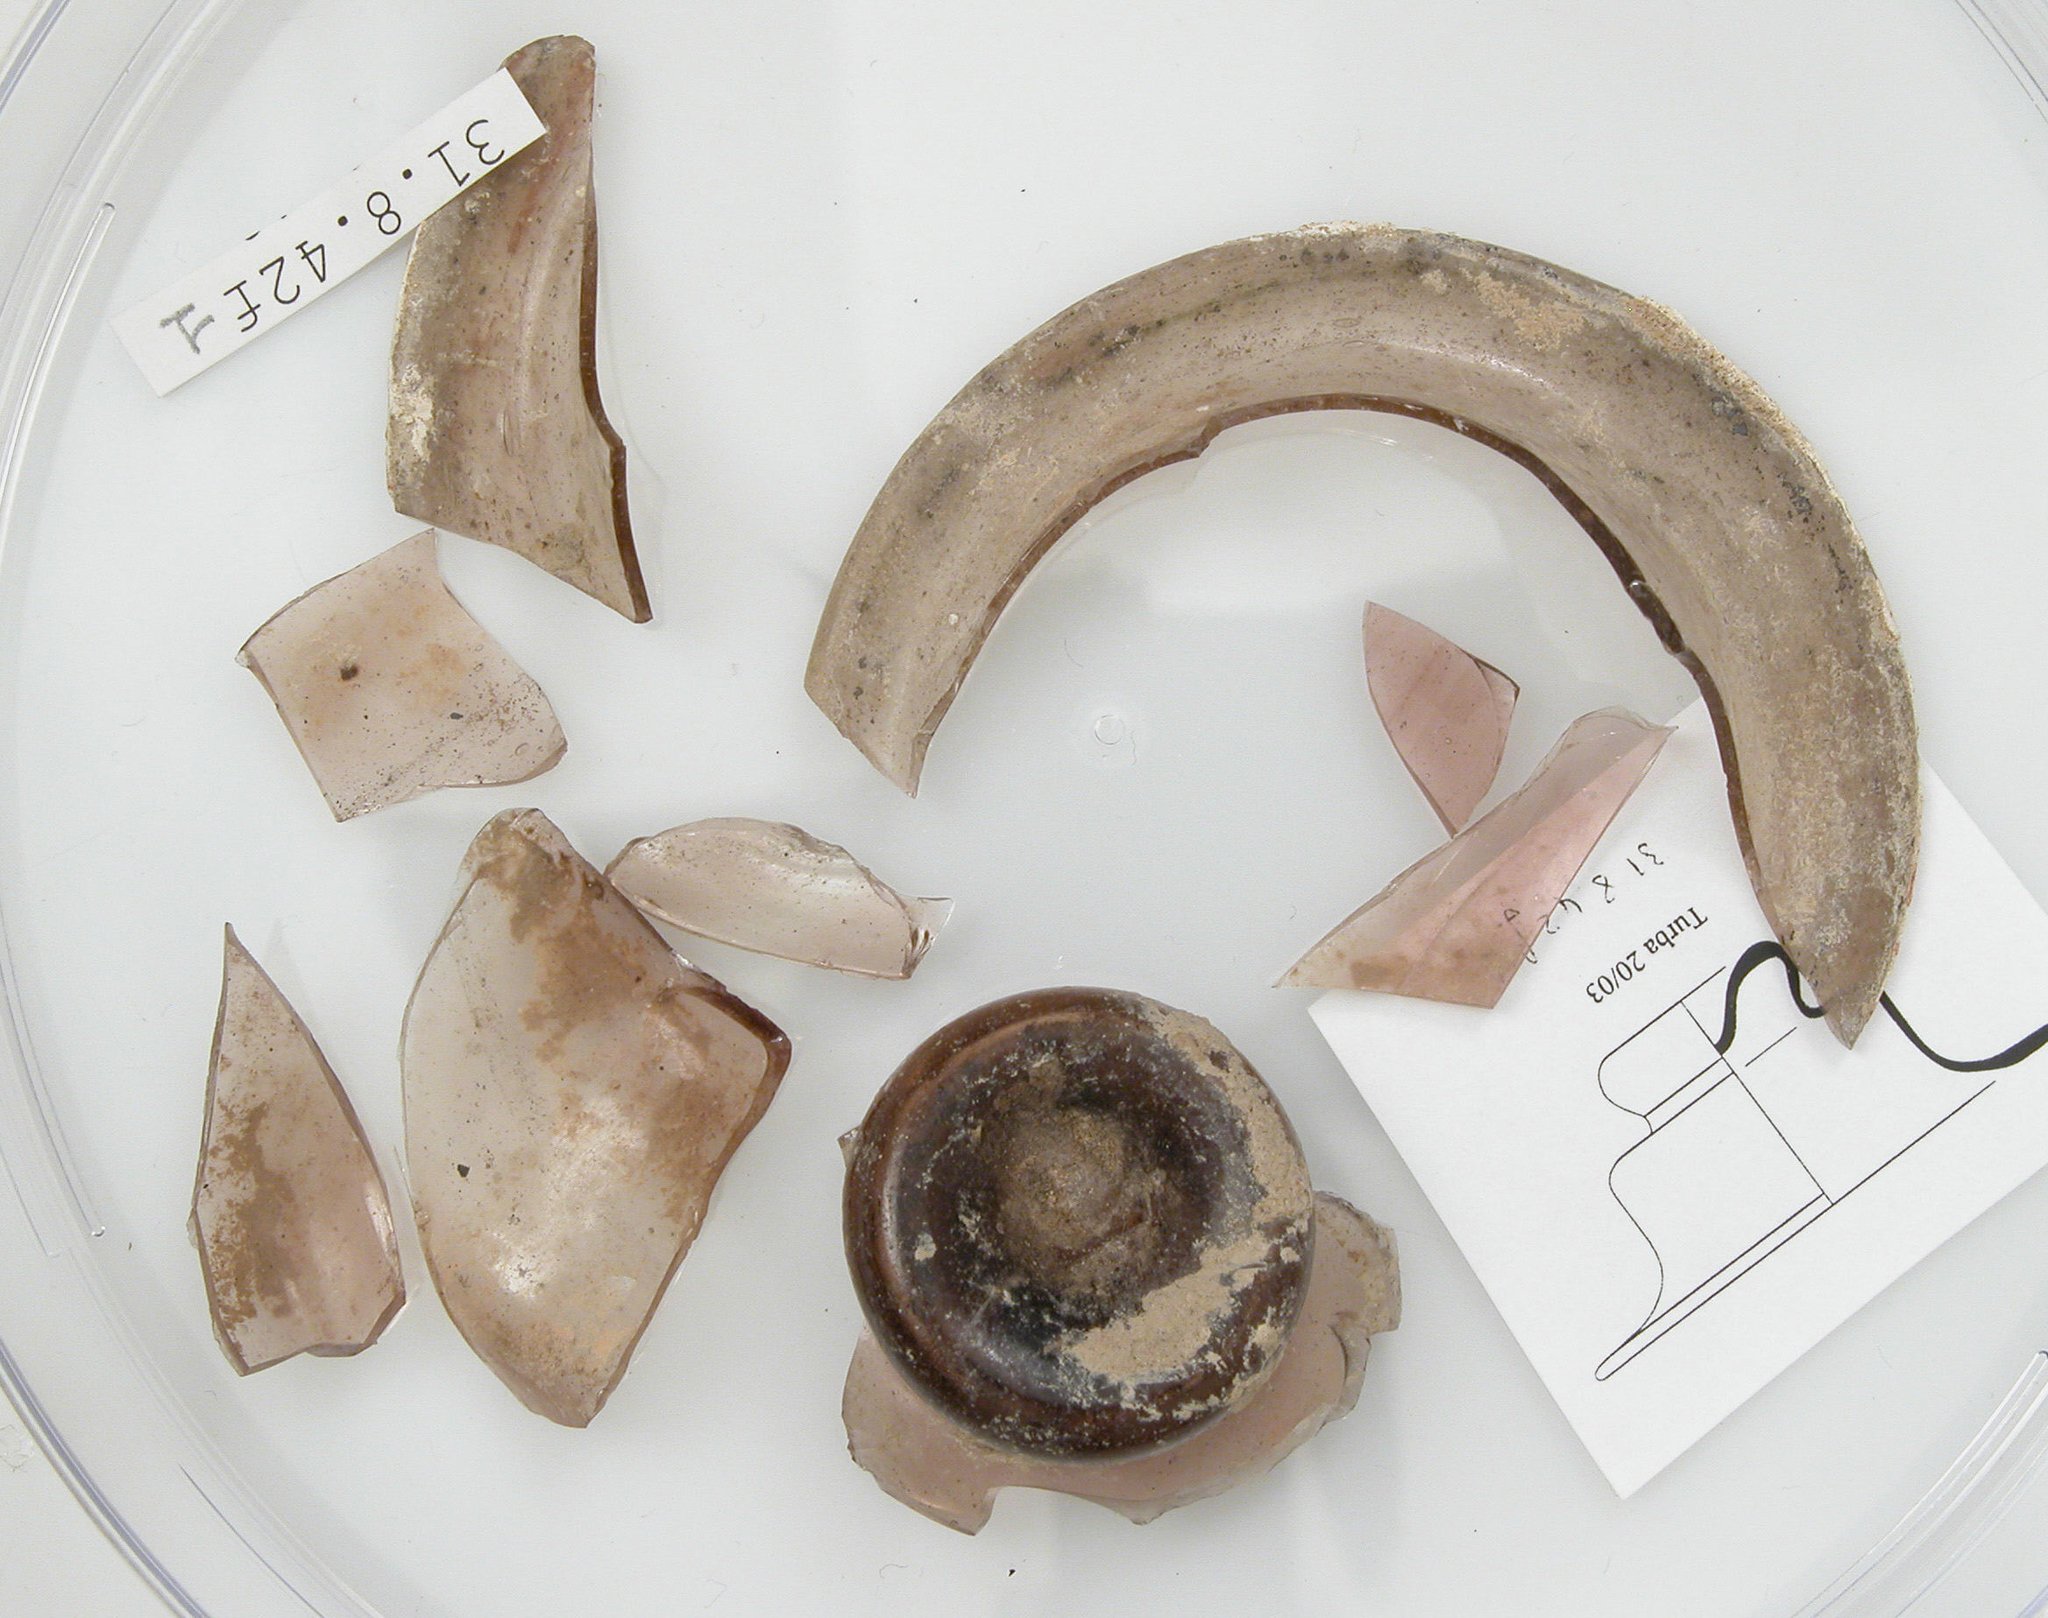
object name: fragment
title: Glass Fragments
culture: coptic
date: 301-400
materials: glass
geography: egypt